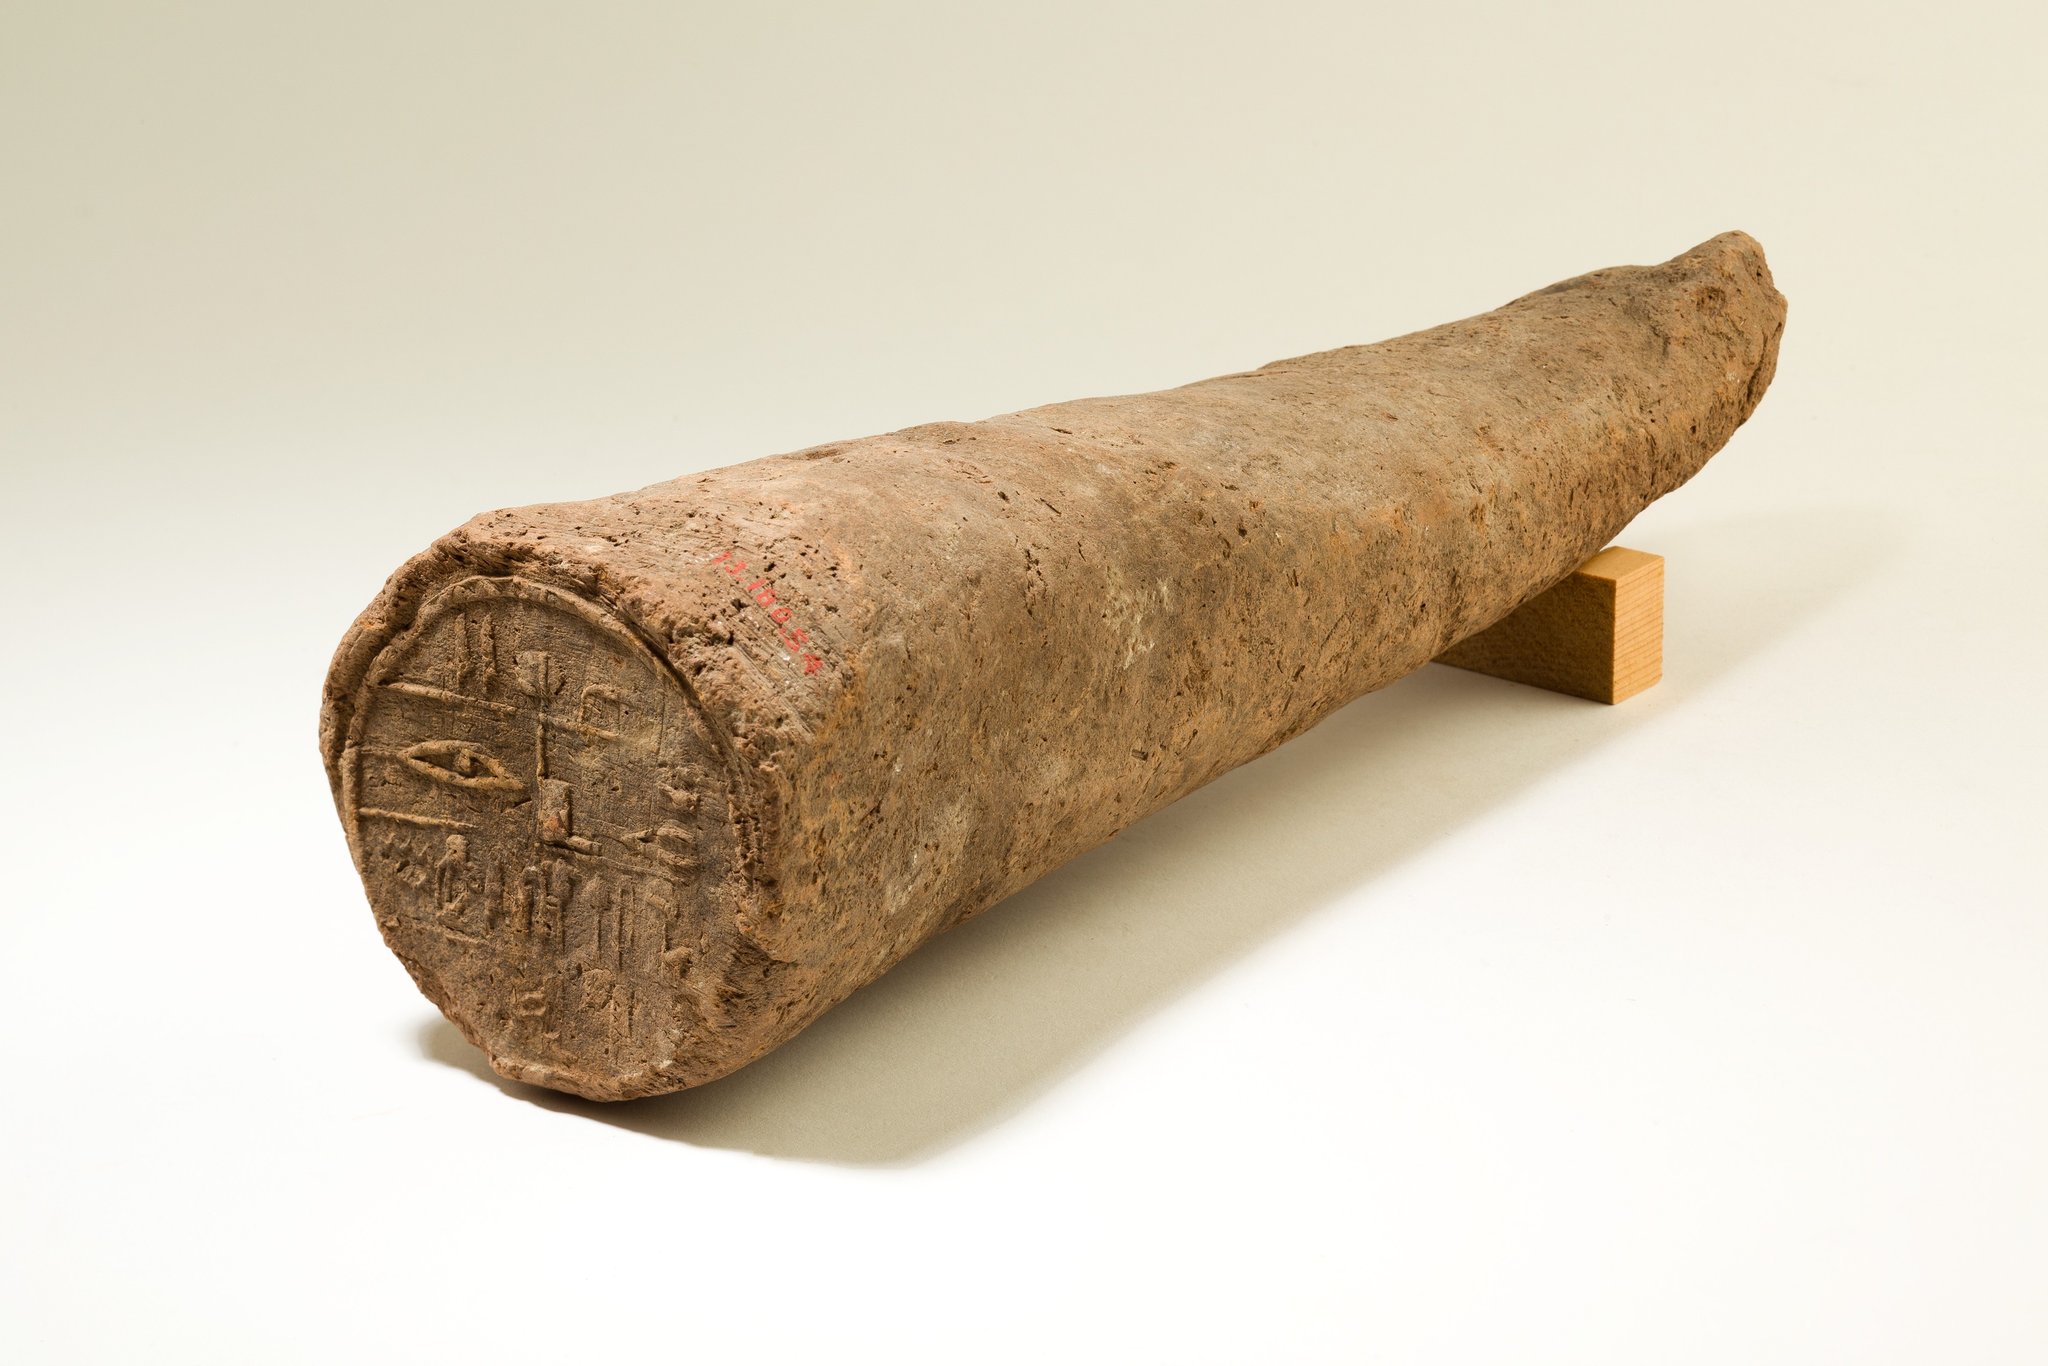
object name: cone, curcular impression, ineni, inspector of scribe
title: Funerary Cone of the Inspector of Scribes Ineni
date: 1550-1295 BCE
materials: pottery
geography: egypt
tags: hieroglyphs